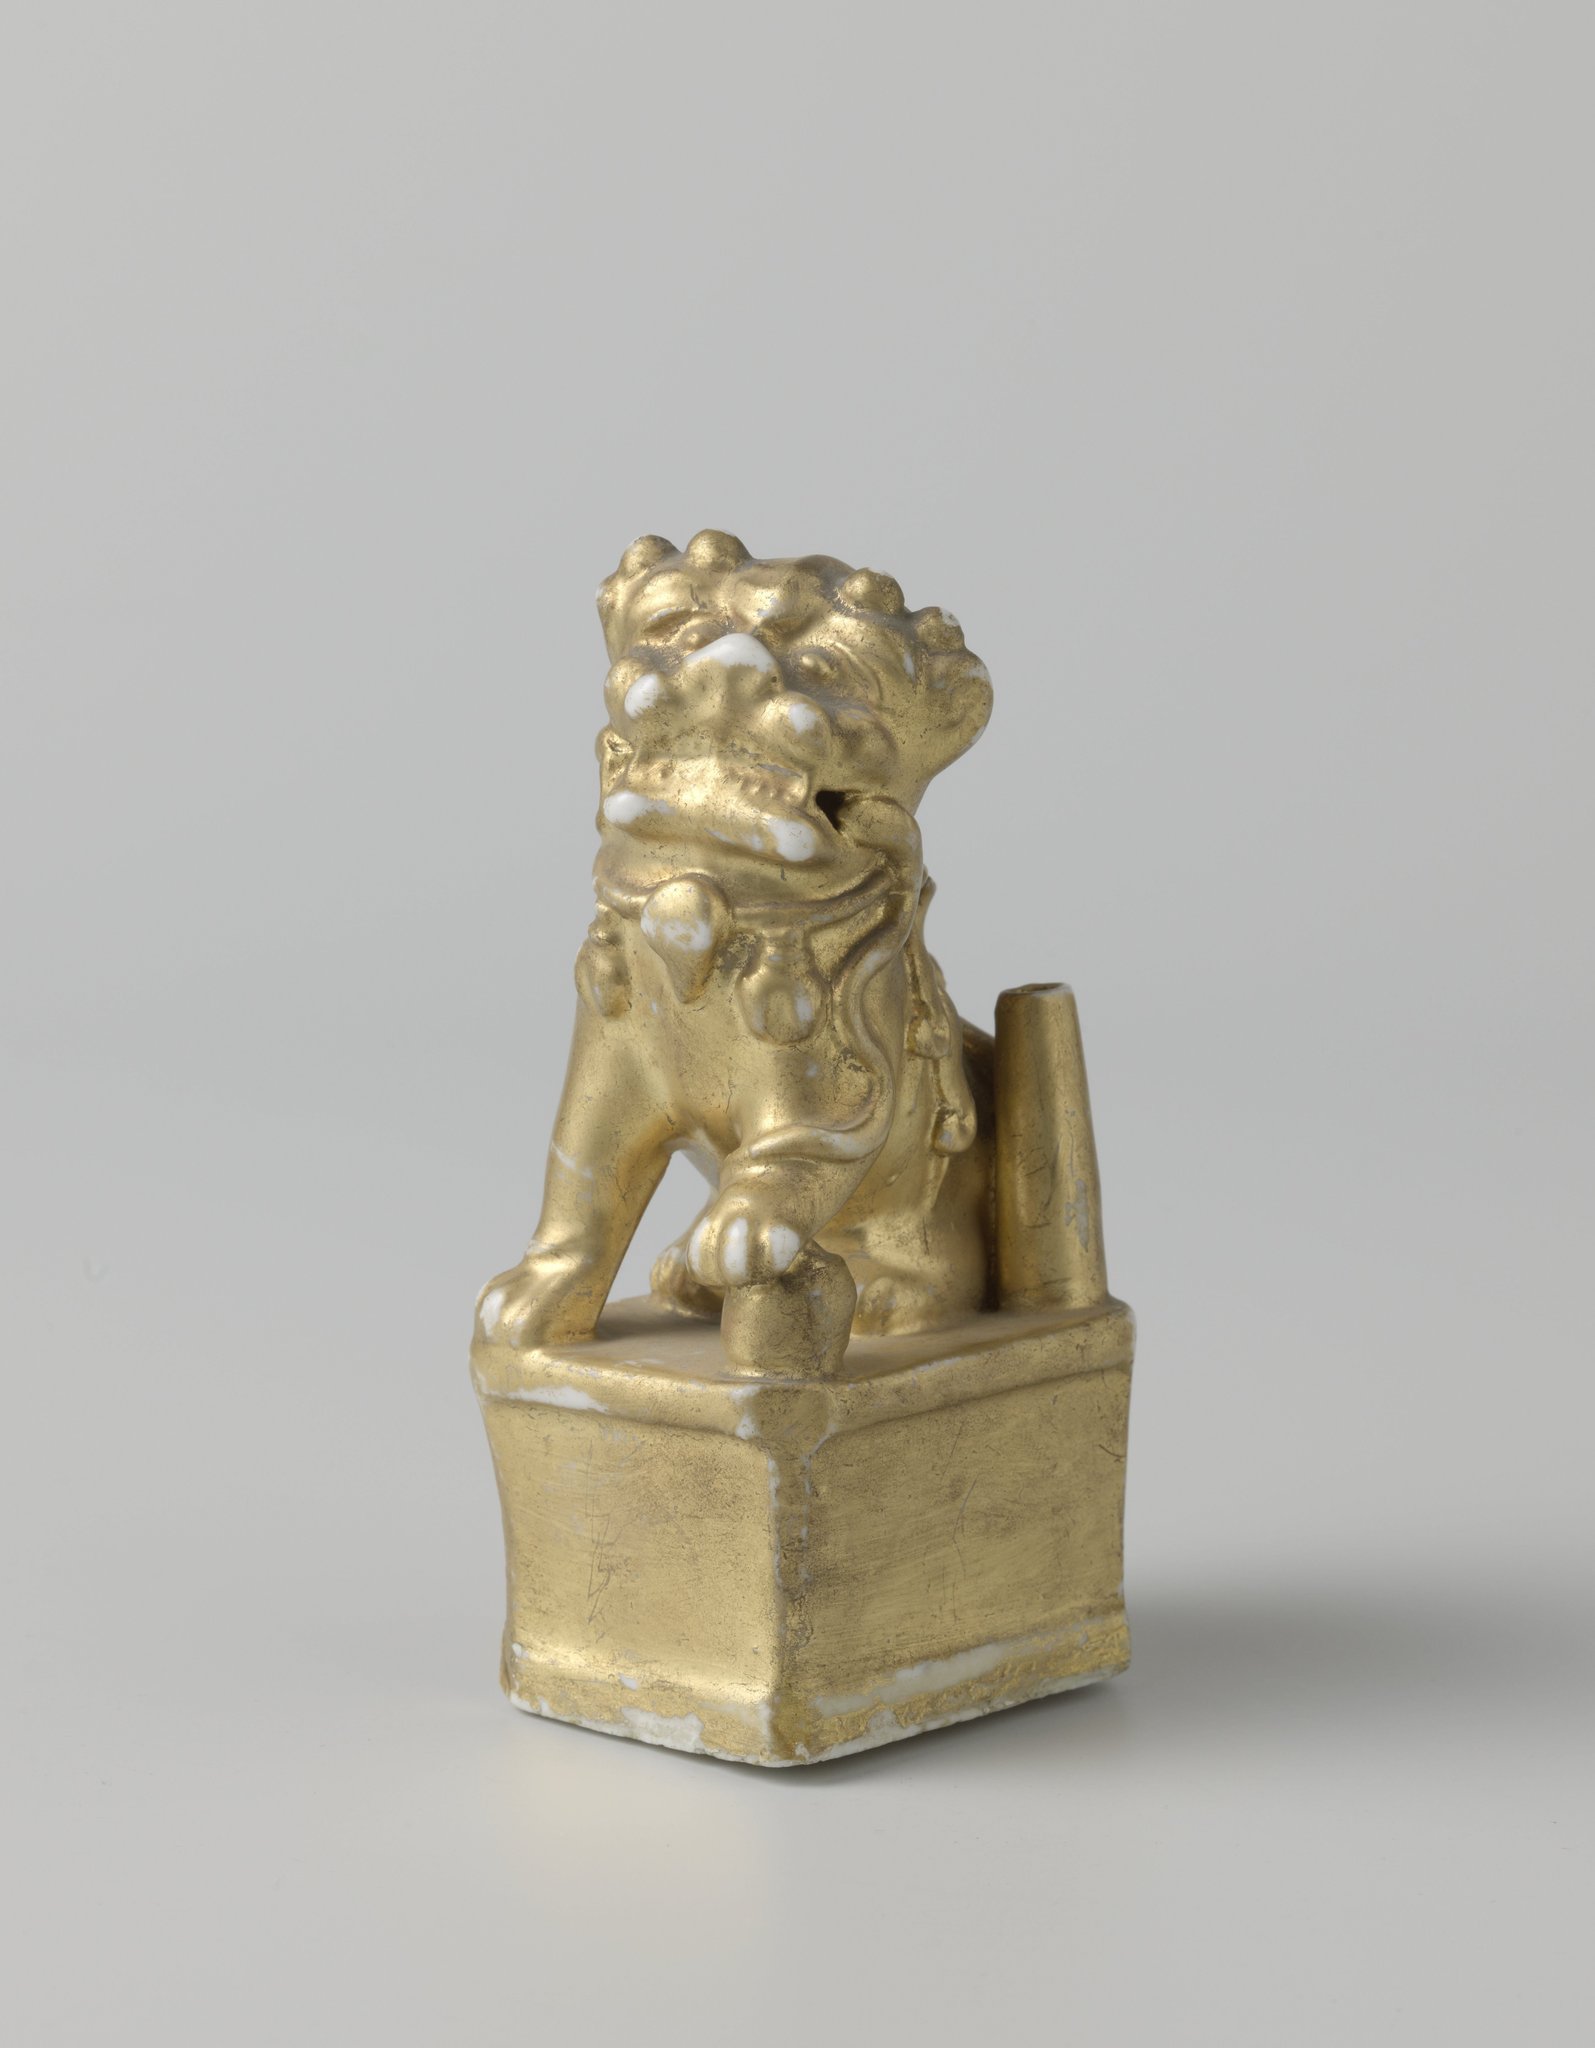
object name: figure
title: Figure of a shishi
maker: Anonymous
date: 1700-1799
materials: glaze, porcelain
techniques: firing, forming, vitrification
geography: china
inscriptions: label: ‘Collectie Loudon’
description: Beeld van porselein op voetstuk, bedekt met een doorschijnend wit glazuur. Een shishi (leeuwhond) met de rechterpoot op een bal op een rechthoekig voetstuk; met houder voor een wierookstok. In Europa verguld. Oud label op de onderzijde met 'Collectie Loudon'. Blanc de Chine.